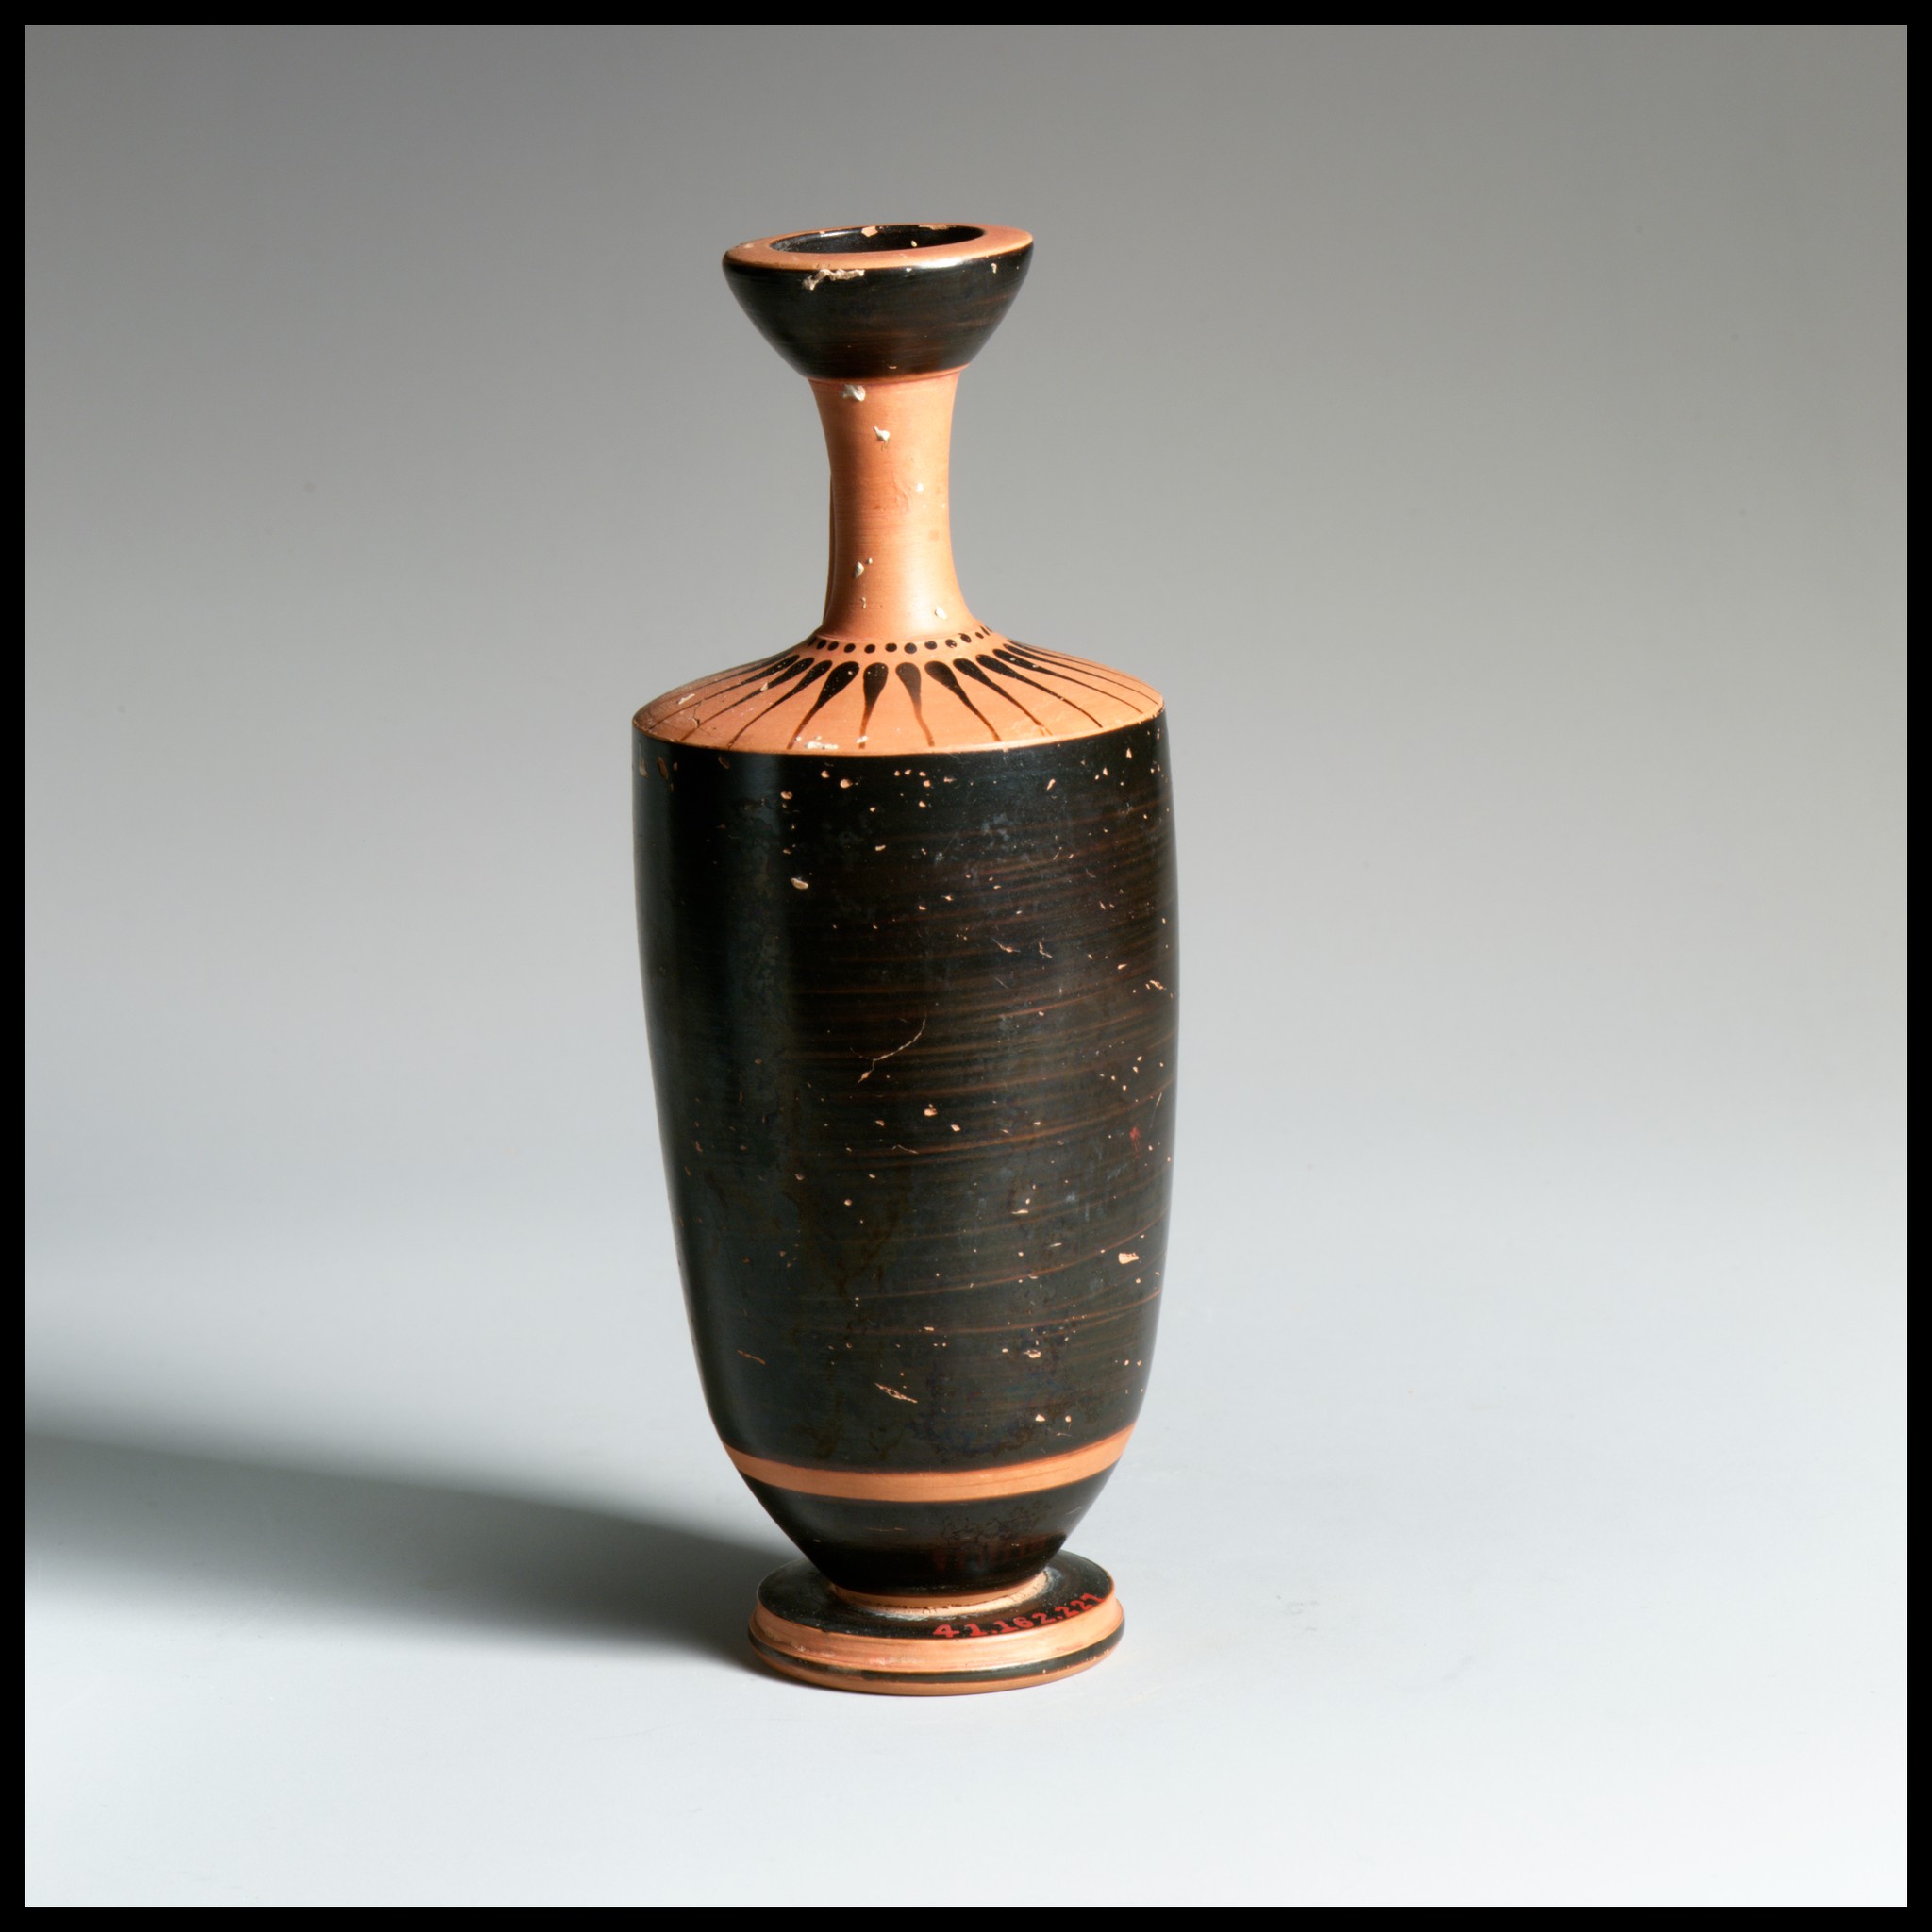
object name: lekythos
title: Terracotta lekythos (oil flask)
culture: greek, attic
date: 500-476 BCE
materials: terracotta